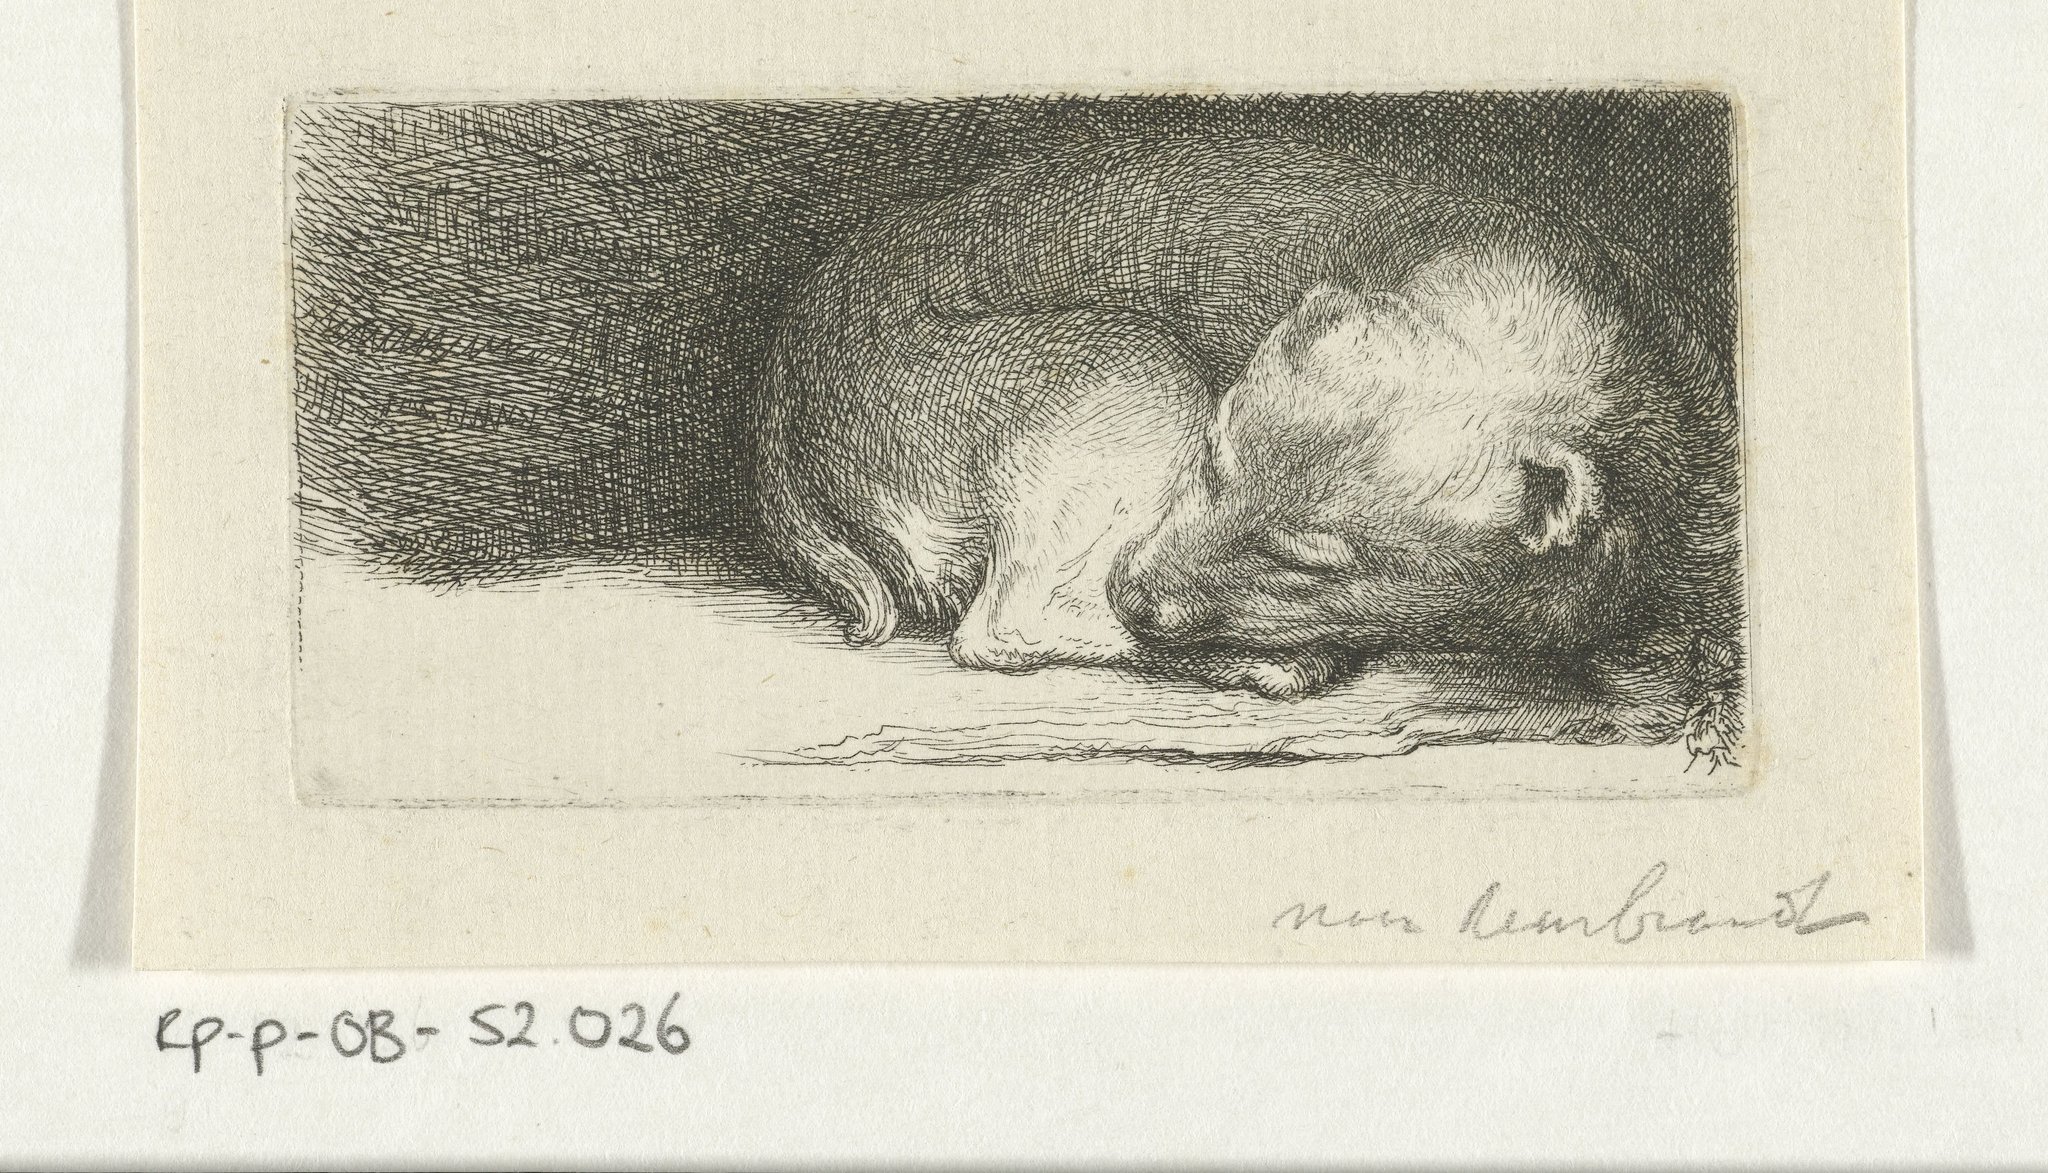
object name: print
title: Slapend hondje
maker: jacob folkema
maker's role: draughtsman, print maker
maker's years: 1692-1767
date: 1702-1767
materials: paper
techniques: etching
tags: dog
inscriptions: collector's mark: Lugt 240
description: Kopie naar de gelijknamige prent van Rembrandt.